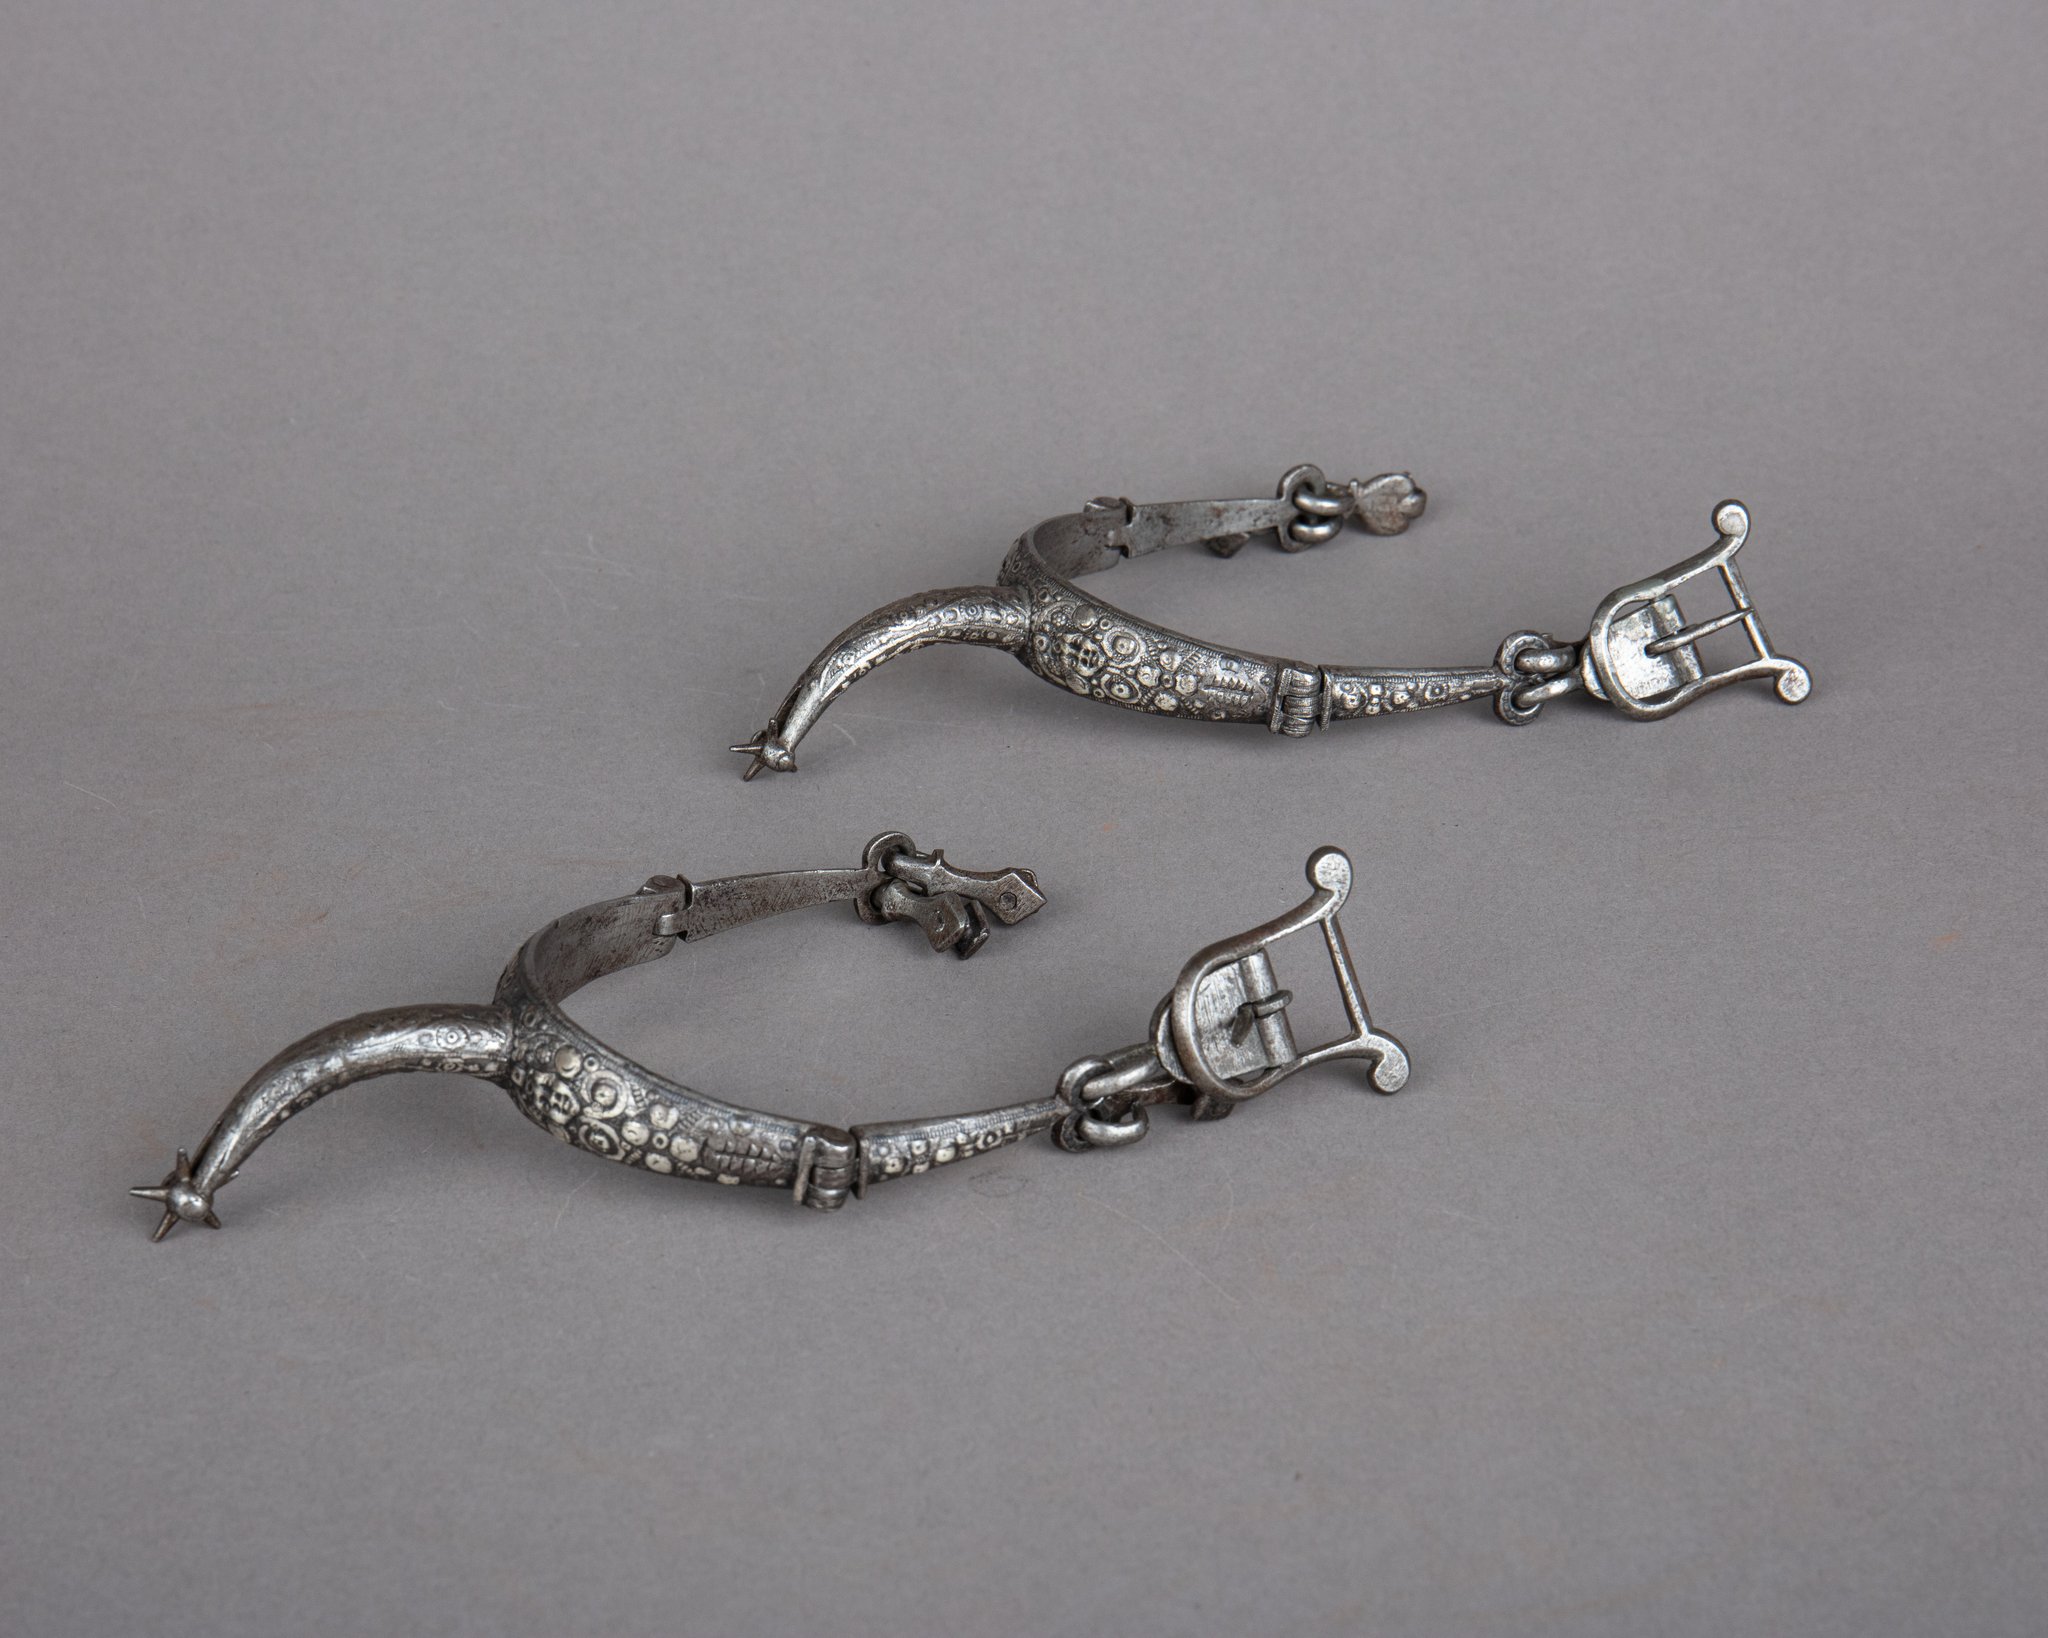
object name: spur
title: Pair of Rowel Spurs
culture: german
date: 1651-1700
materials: metal alloy, silver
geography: germany